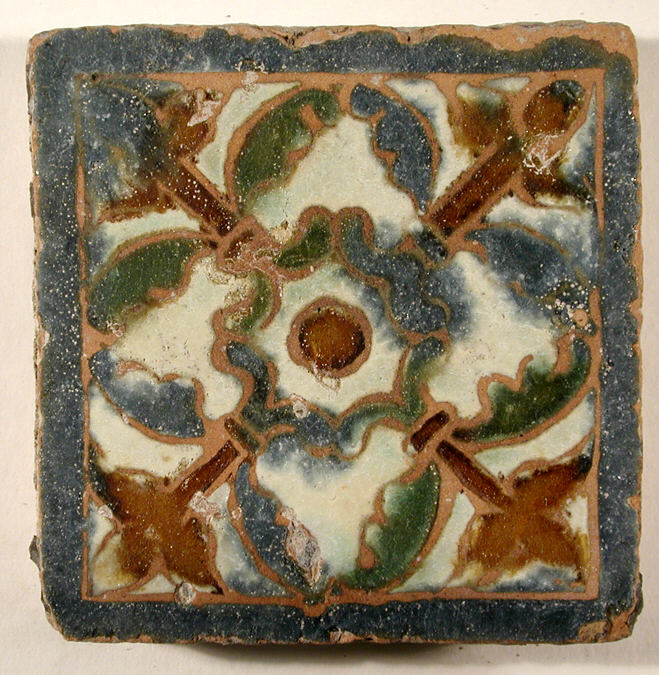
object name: pavement tile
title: Pavement tiles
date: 1501-1700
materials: earthenware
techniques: glazing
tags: leaves